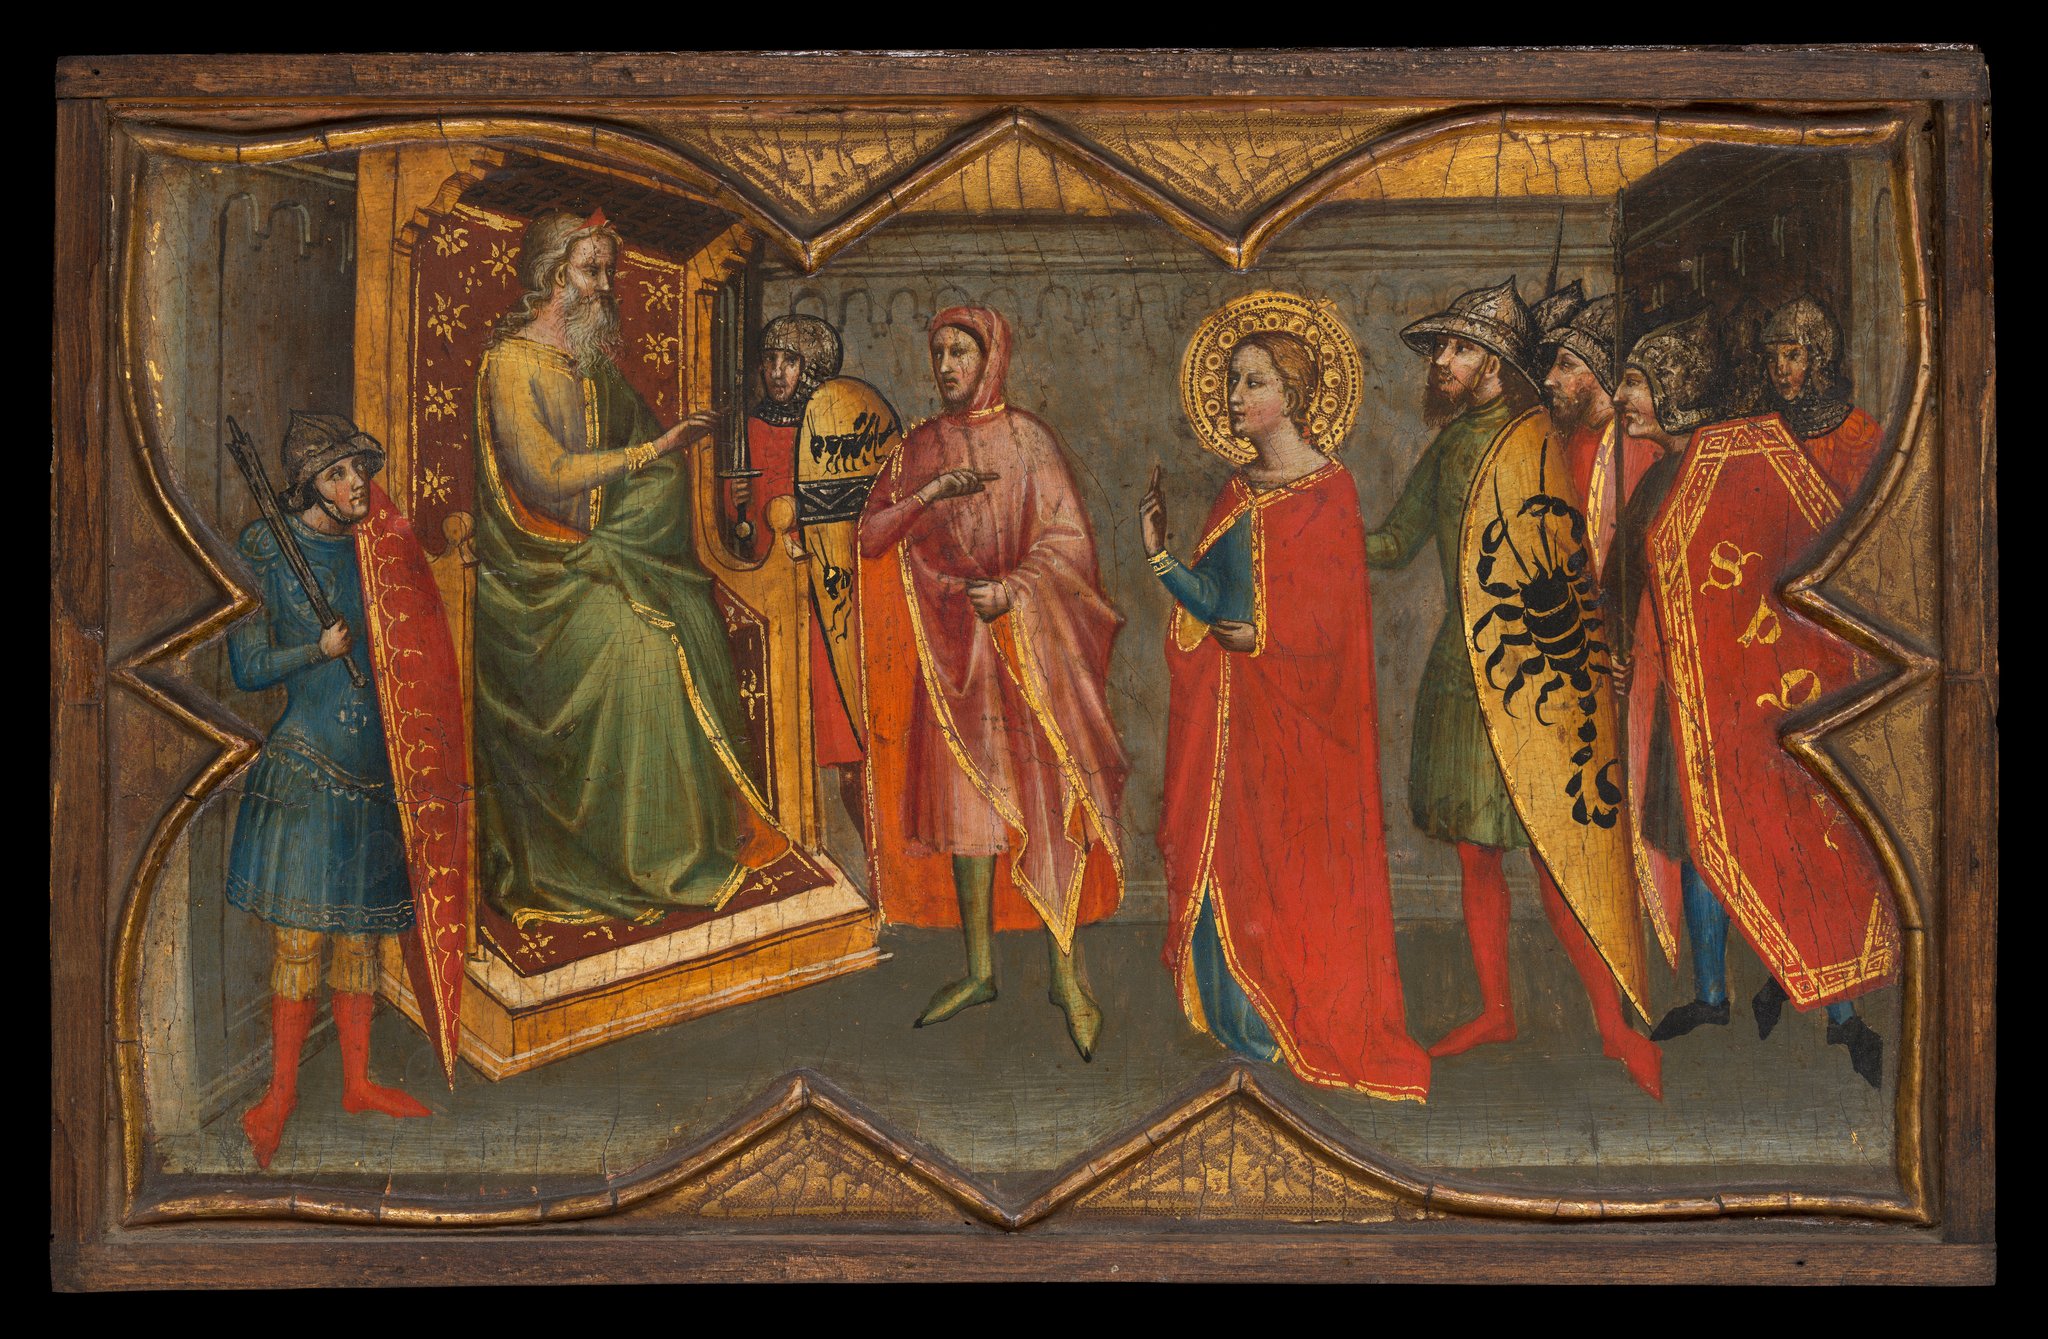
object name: painting, part of an altarpiece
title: Saint Lucy and Her Mother at the Shrine of Saint Agatha; Saint Lucy Giving Alms; Saint Lucy before Paschasius; Saint Lucy Resisting Efforts to Move Her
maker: giovanni di bartolommeo cristiani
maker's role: artist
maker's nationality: italian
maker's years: 1367-1398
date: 1367-1398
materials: gold leaf, paint, wood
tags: soldiers,men,women,cows,angels,saints